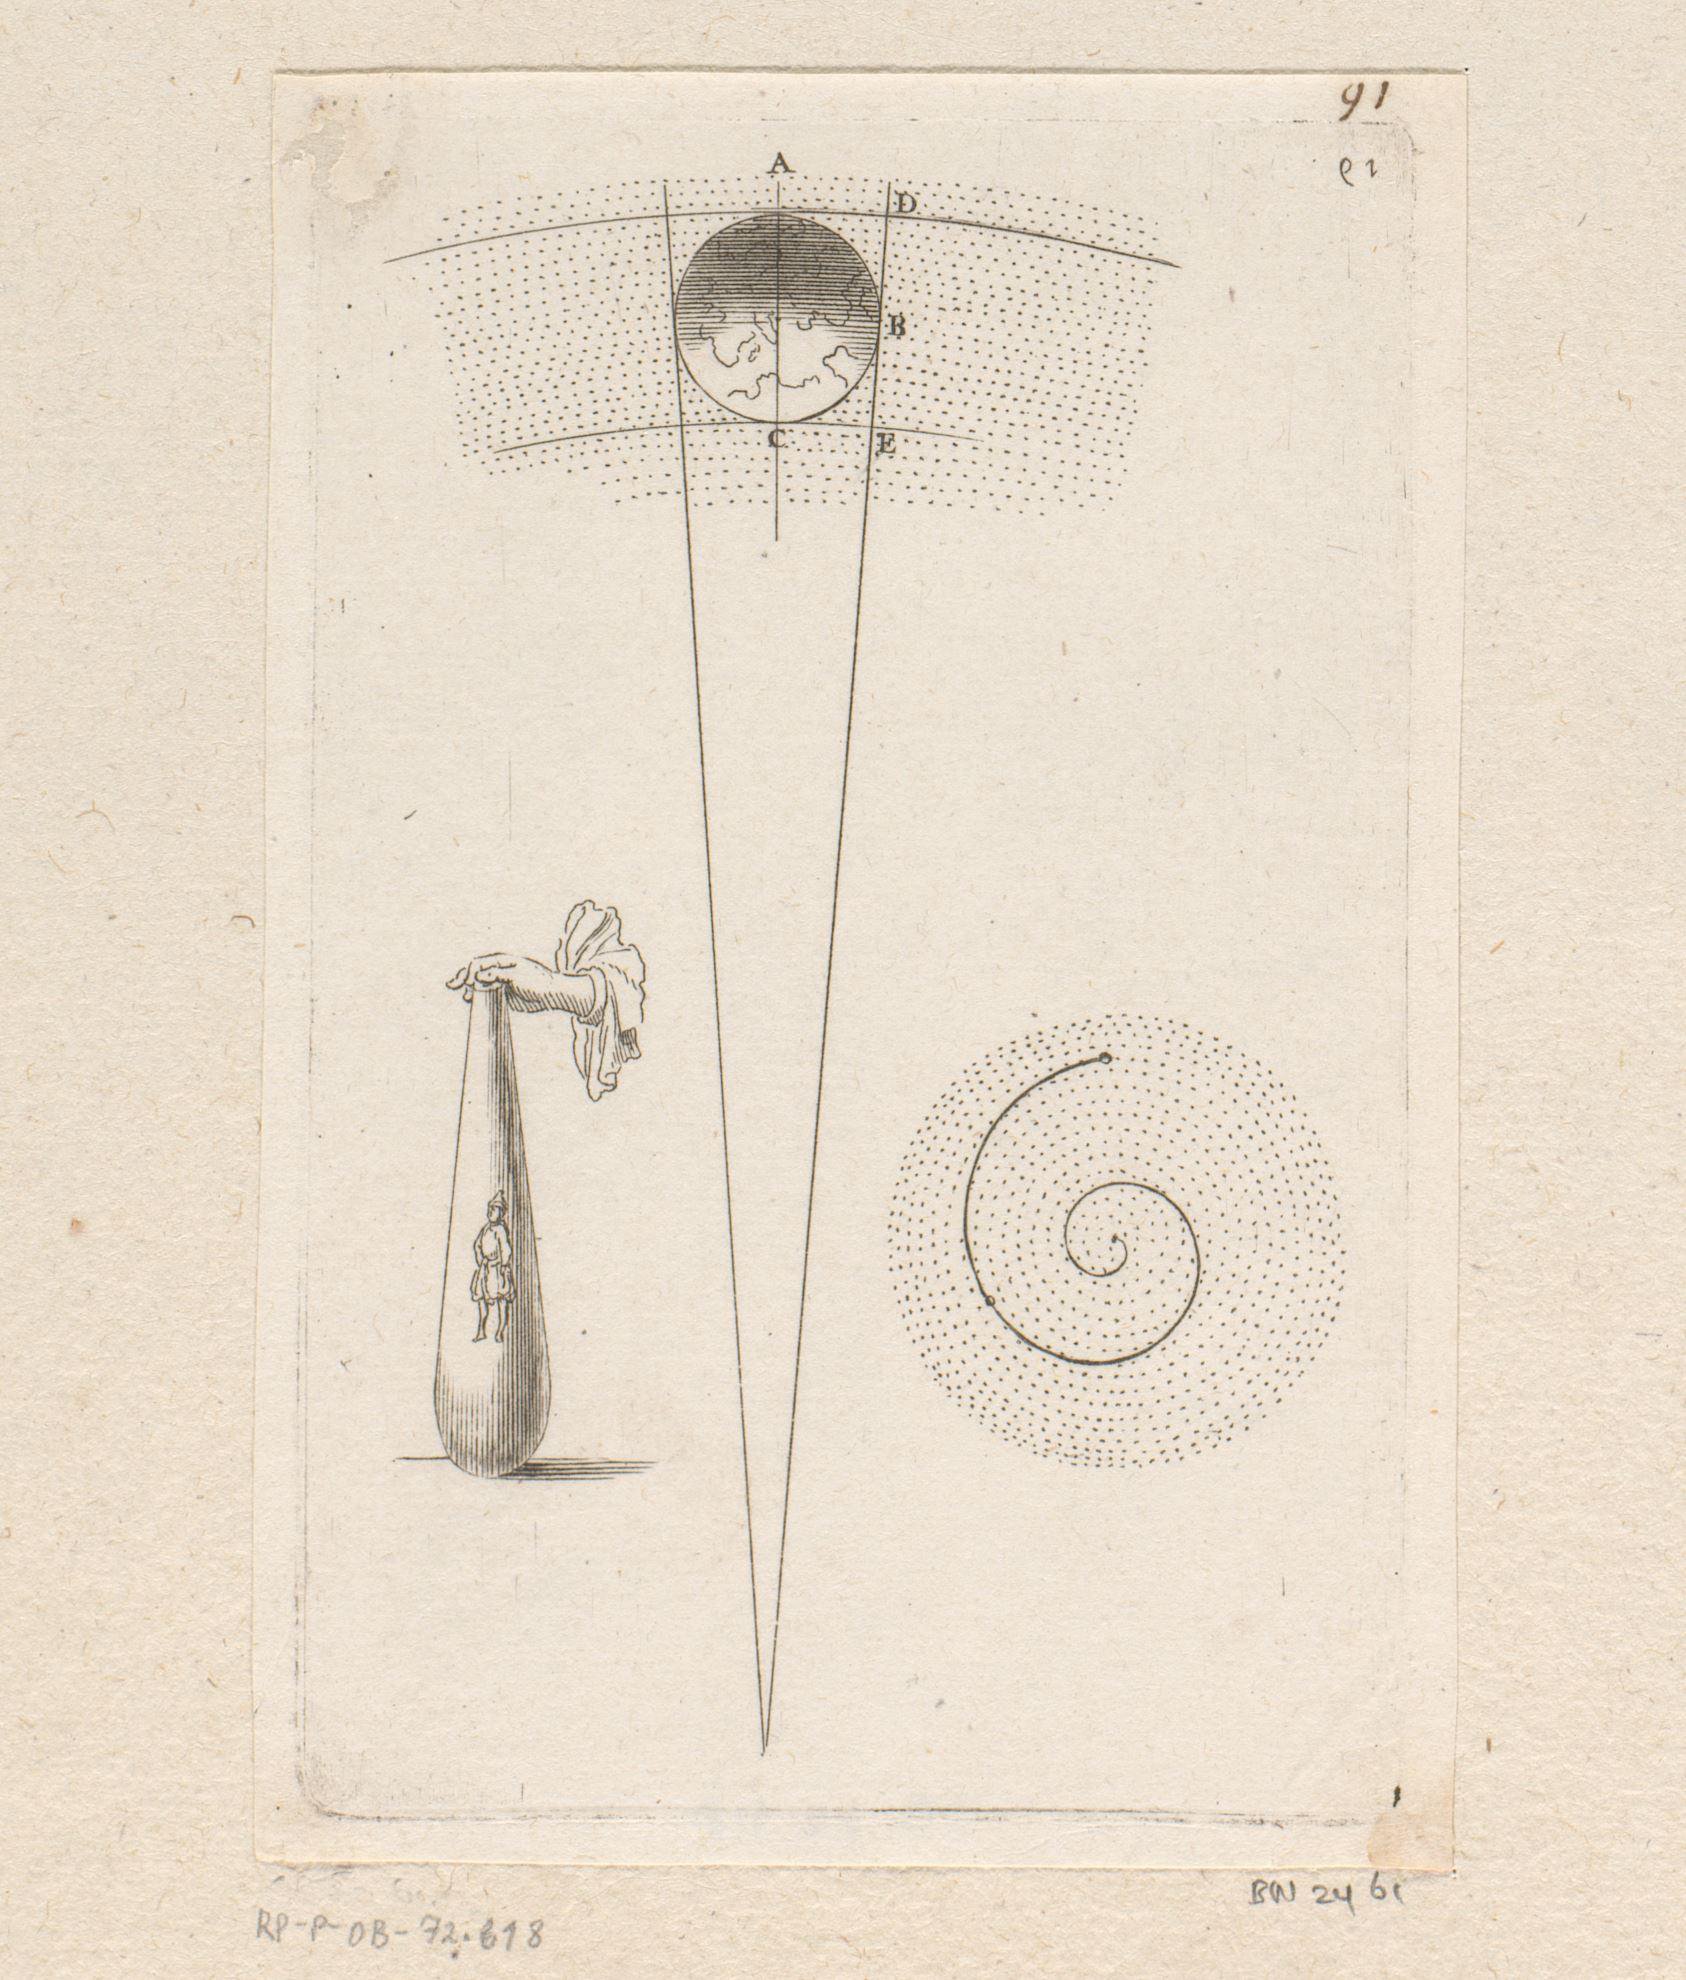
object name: print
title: Aarde, spiraal en fles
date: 1706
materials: paper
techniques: etching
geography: paris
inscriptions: number: ‘91’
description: Prent uit: Leclerc, Sébastien. Nouveau systeme du monde conforme à l'Ecriture sainte. Où les phénomènes sont expliquez sans excentricité de mouvement (...). Paris: Pierre Giffart, 1706.